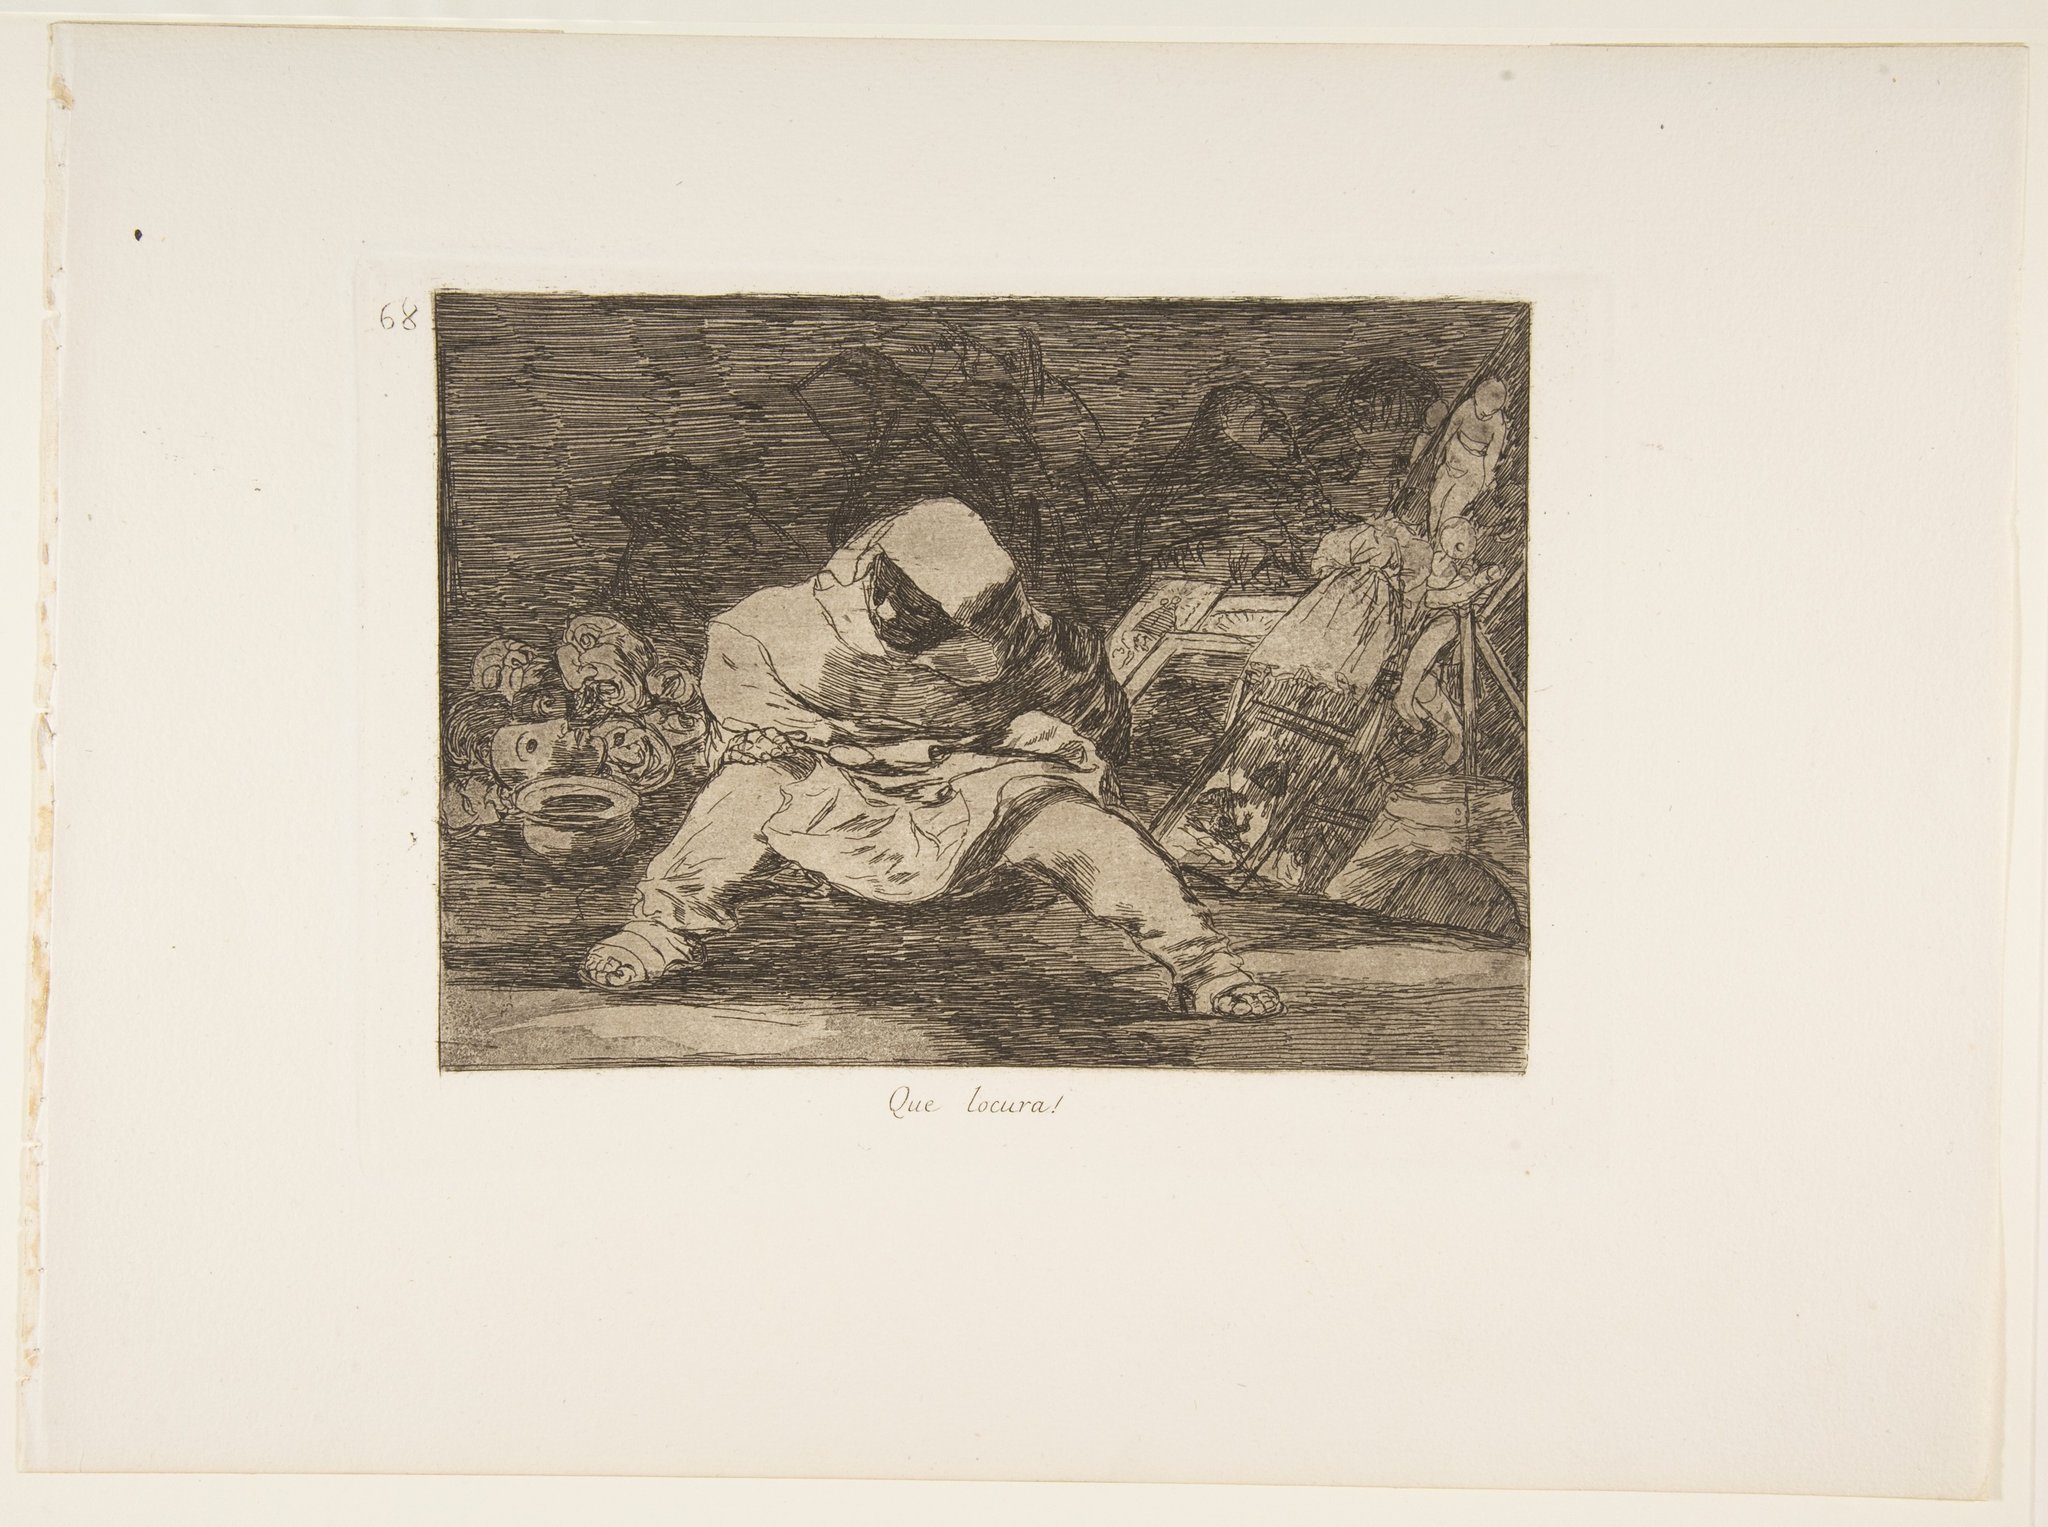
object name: print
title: Plate 68 from "The Disasters of War" (Los Desastres de la Guerra): 'What madness!' (Que locura!)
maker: goya (francisco de goya y lucientes)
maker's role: artist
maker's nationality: spanish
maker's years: 1746-1828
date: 1814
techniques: engraving, etching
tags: men